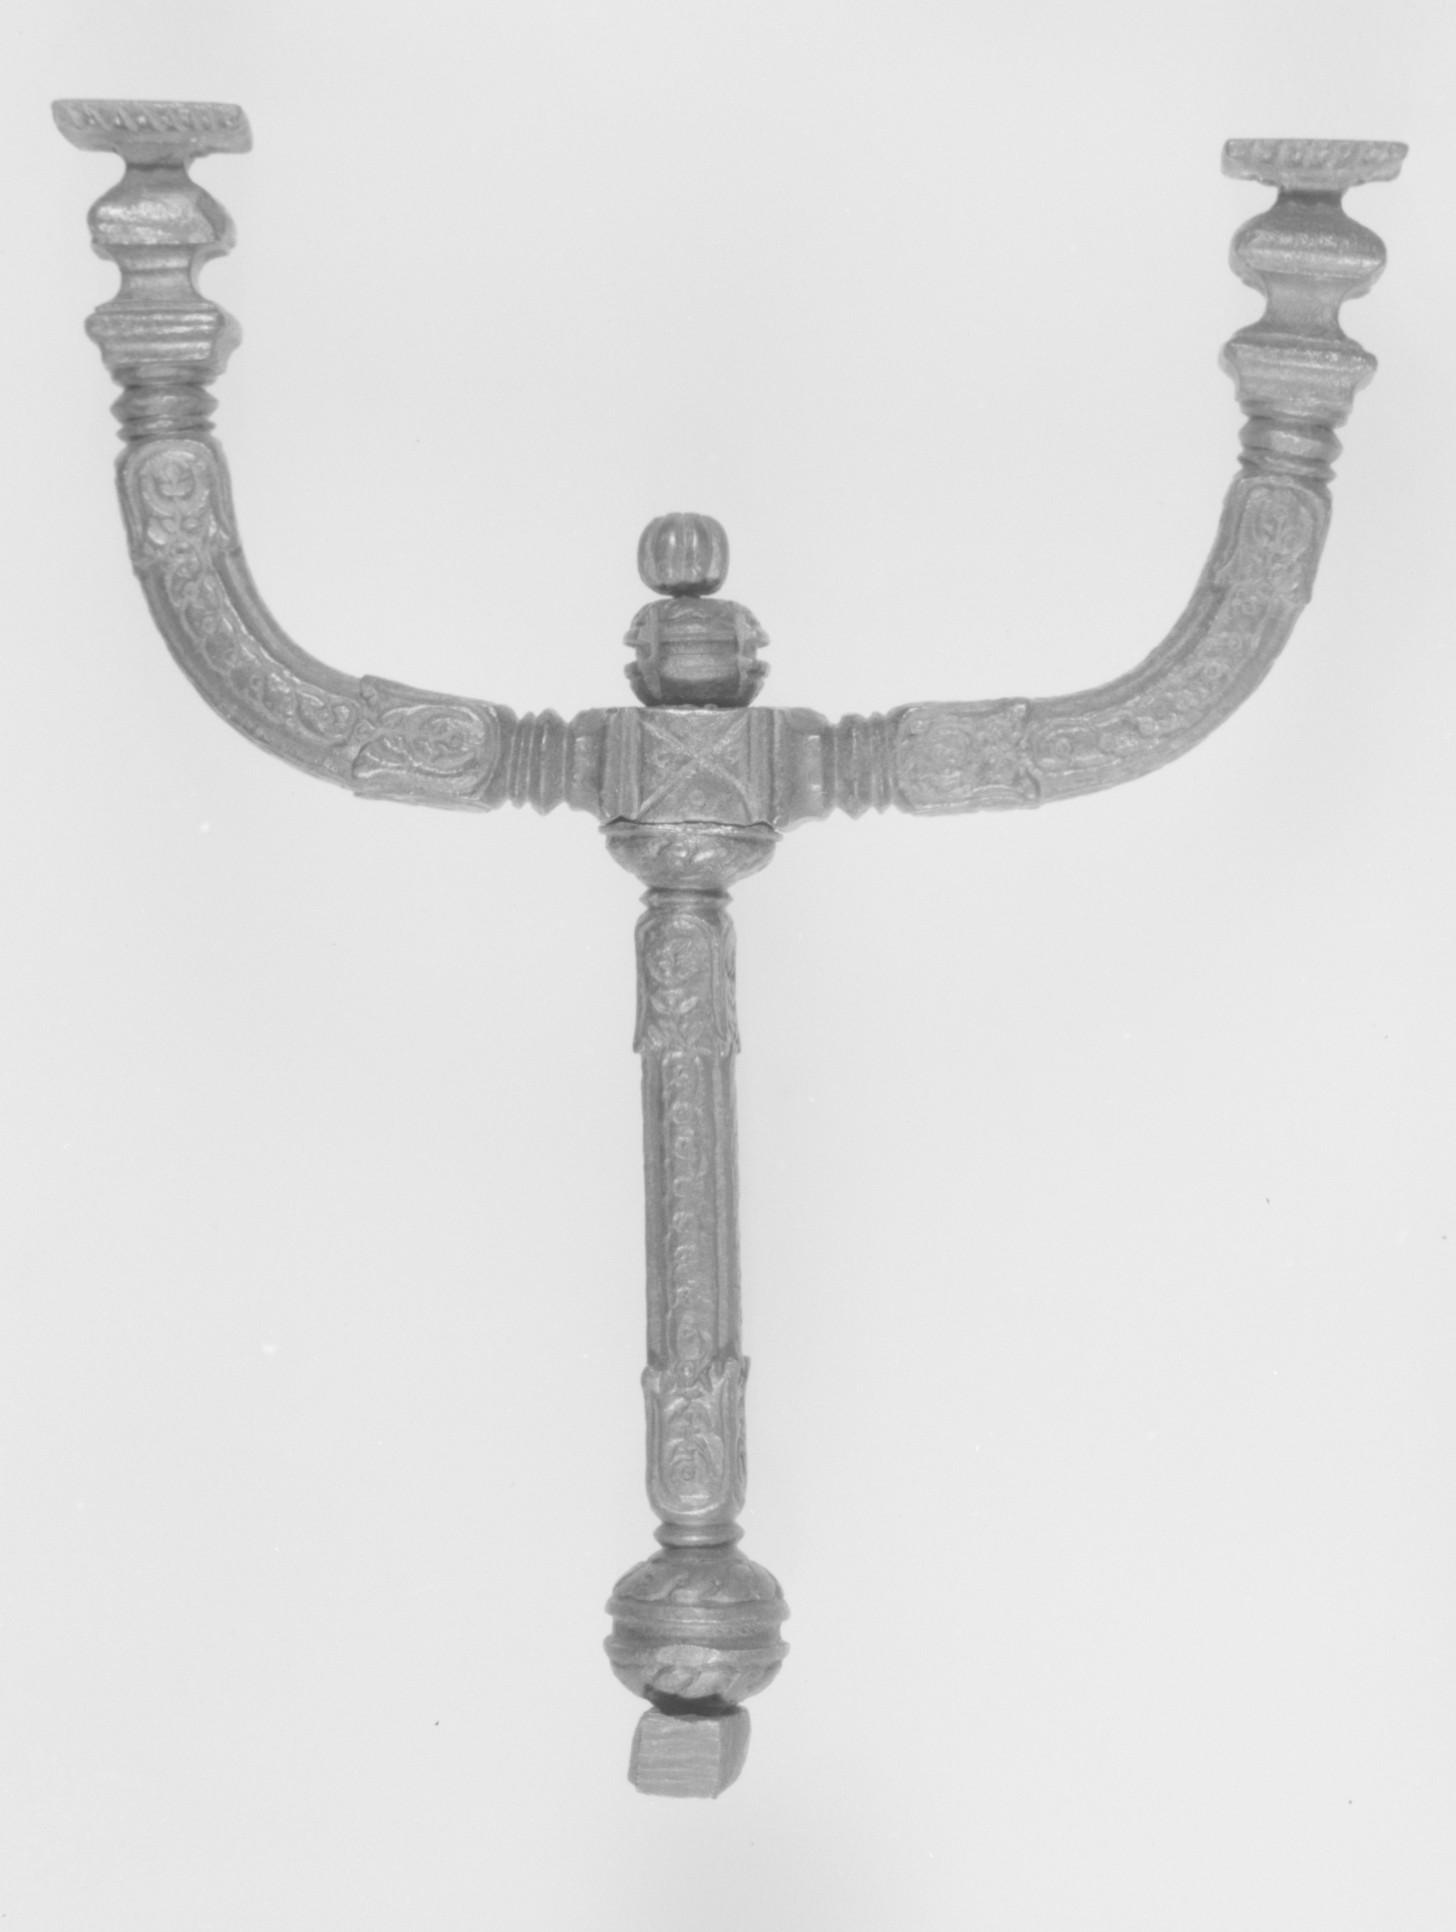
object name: bed leg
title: Bed leg (one of four)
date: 1501-1600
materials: iron